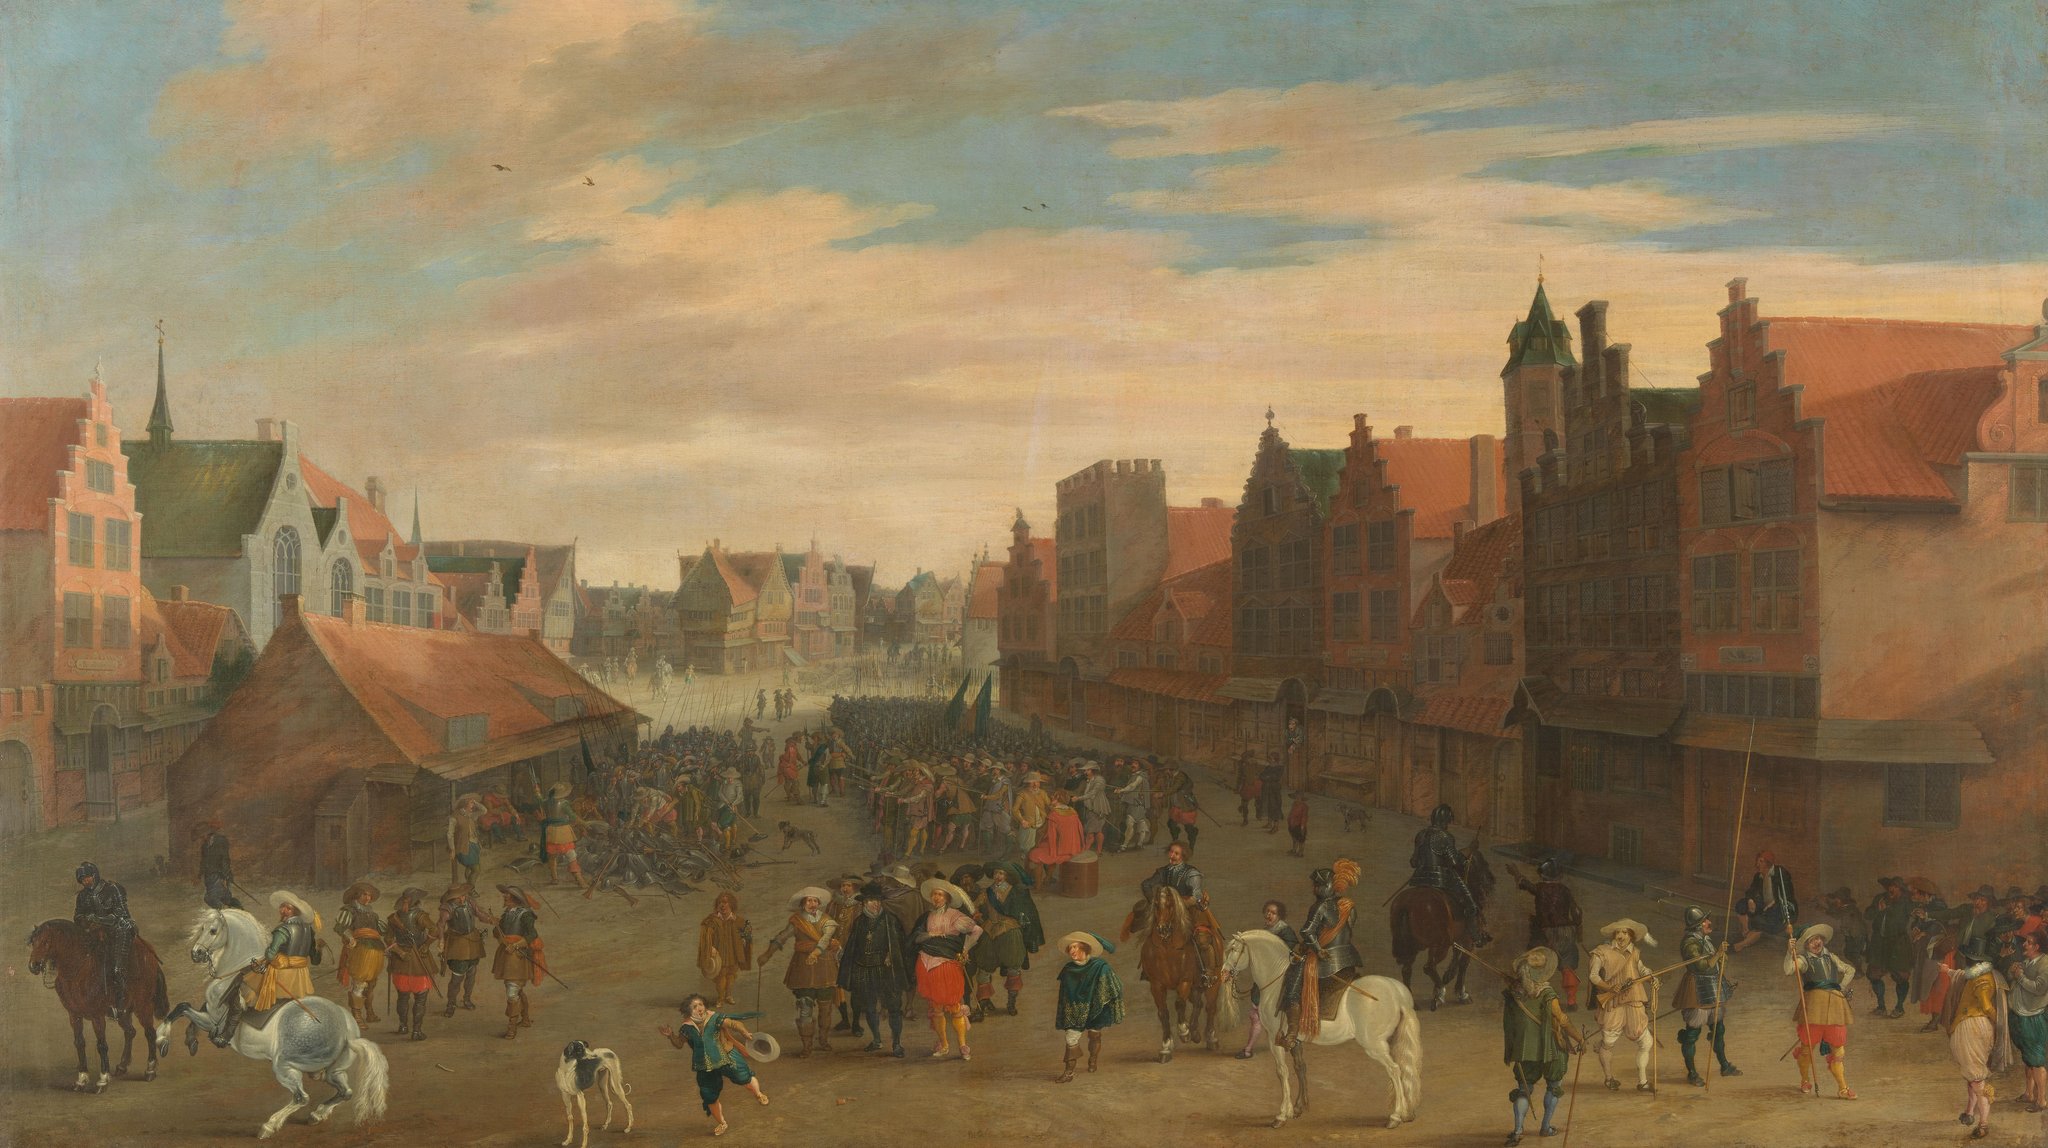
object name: painting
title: The Disbanding of the 'Waardgelders' (Mercenaries in the Pay of the Town Government) by Prince Maurits on the Neude, Utrecht, 31 July 1618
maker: pauwels van hillegaert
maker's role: painter, print maker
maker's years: 1596-1658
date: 1627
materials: canvas, oil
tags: maurice (prince of orange), disbanding of the troops, utrecht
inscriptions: date, on the fourth house on the right: ‘Anno 1627’, signature and date, bottom centre: ‘Pauwels van hilligaert 1627’, signature, on the house on the left: ‘PAwels van hillig’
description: Attired in black, Prince Maurits watches as (mercenary) soldiers – so-called ‘waardgelders’ hired by the towns – here cast off their armour into a sizeable heap. Army commander Maurits put an end to the practice of hiring mercenaries in 1618. By disbanding them, he further consolidated his control over the municipal governments, quashing their ability to defend themselves